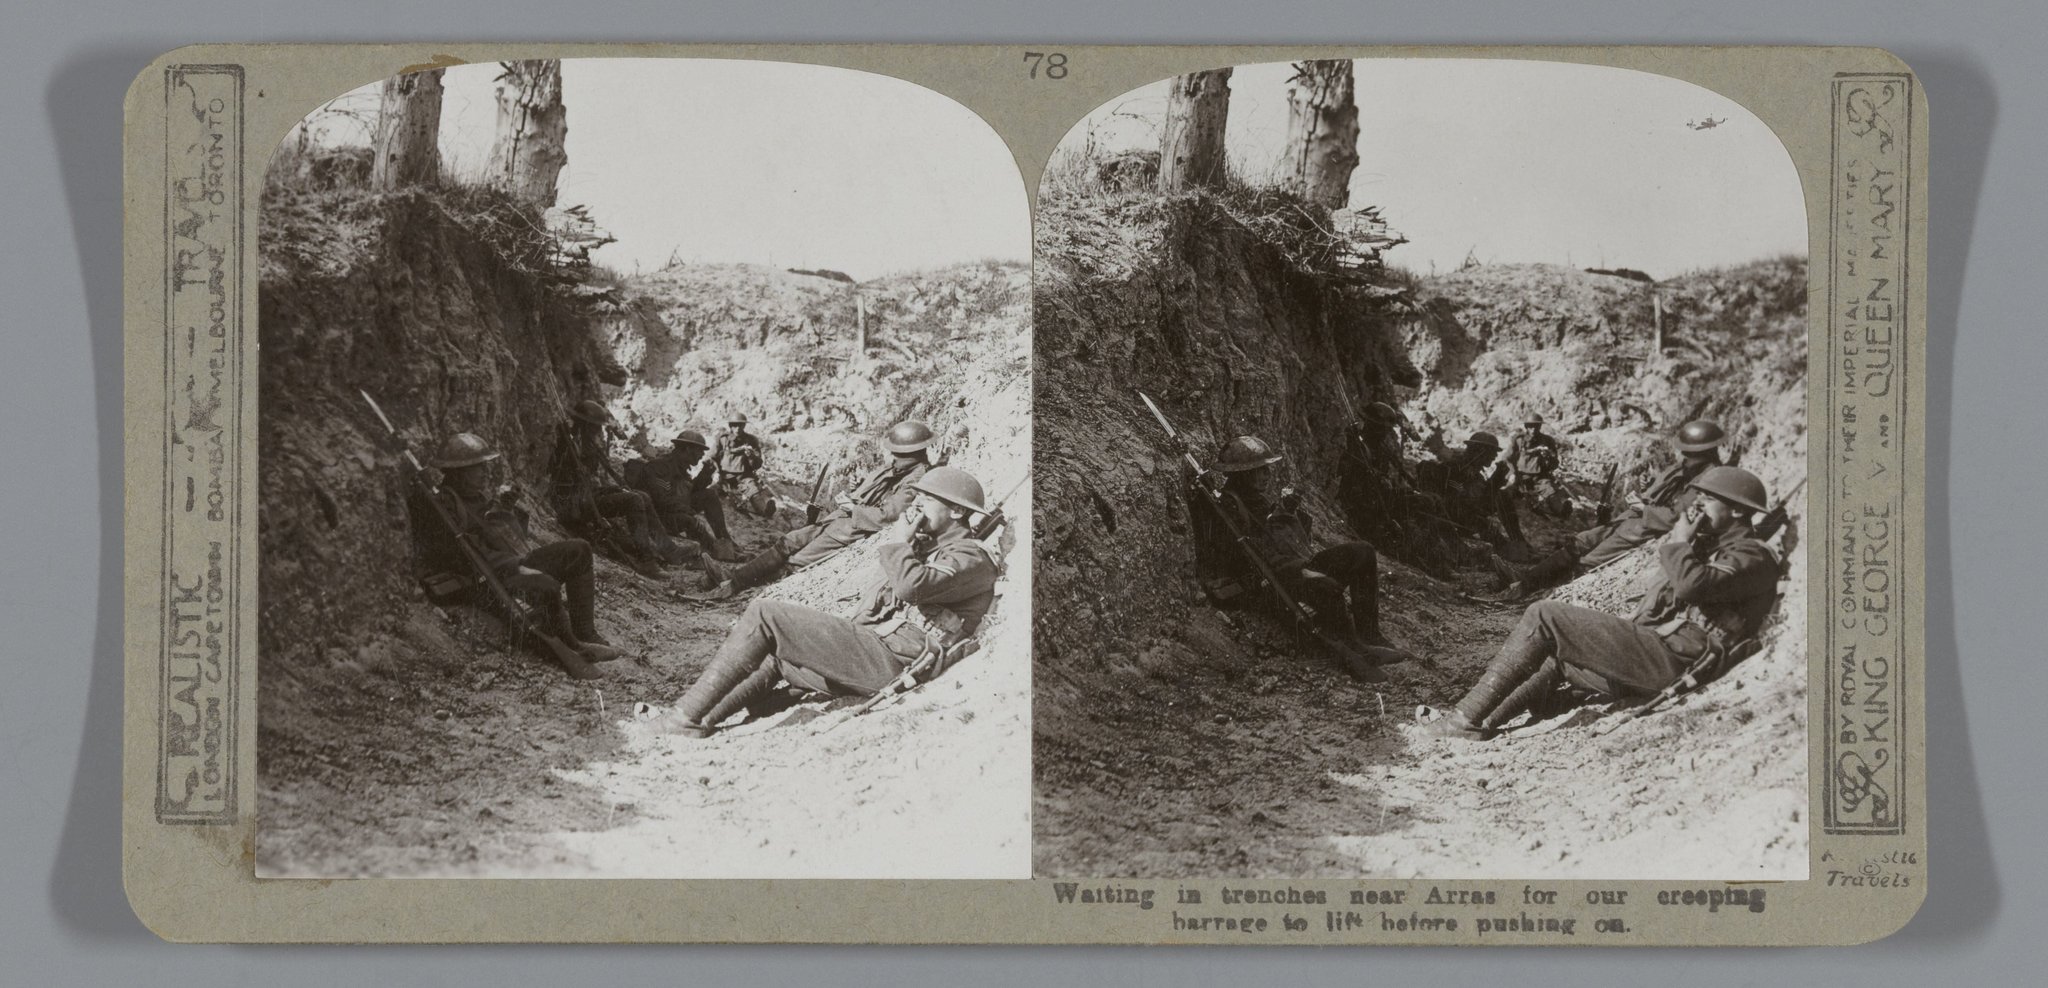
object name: stereograph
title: Waiting in trenches near Arras for our creeping barrage to lift before pushing on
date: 1914-1918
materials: cardboard, photographic support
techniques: gelatin silver print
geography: pas-de-calais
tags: private soldier, trenches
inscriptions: number: ‘78’, inscription: ‘By Royal command to their Imperial majesties King George V and Queen Mary’